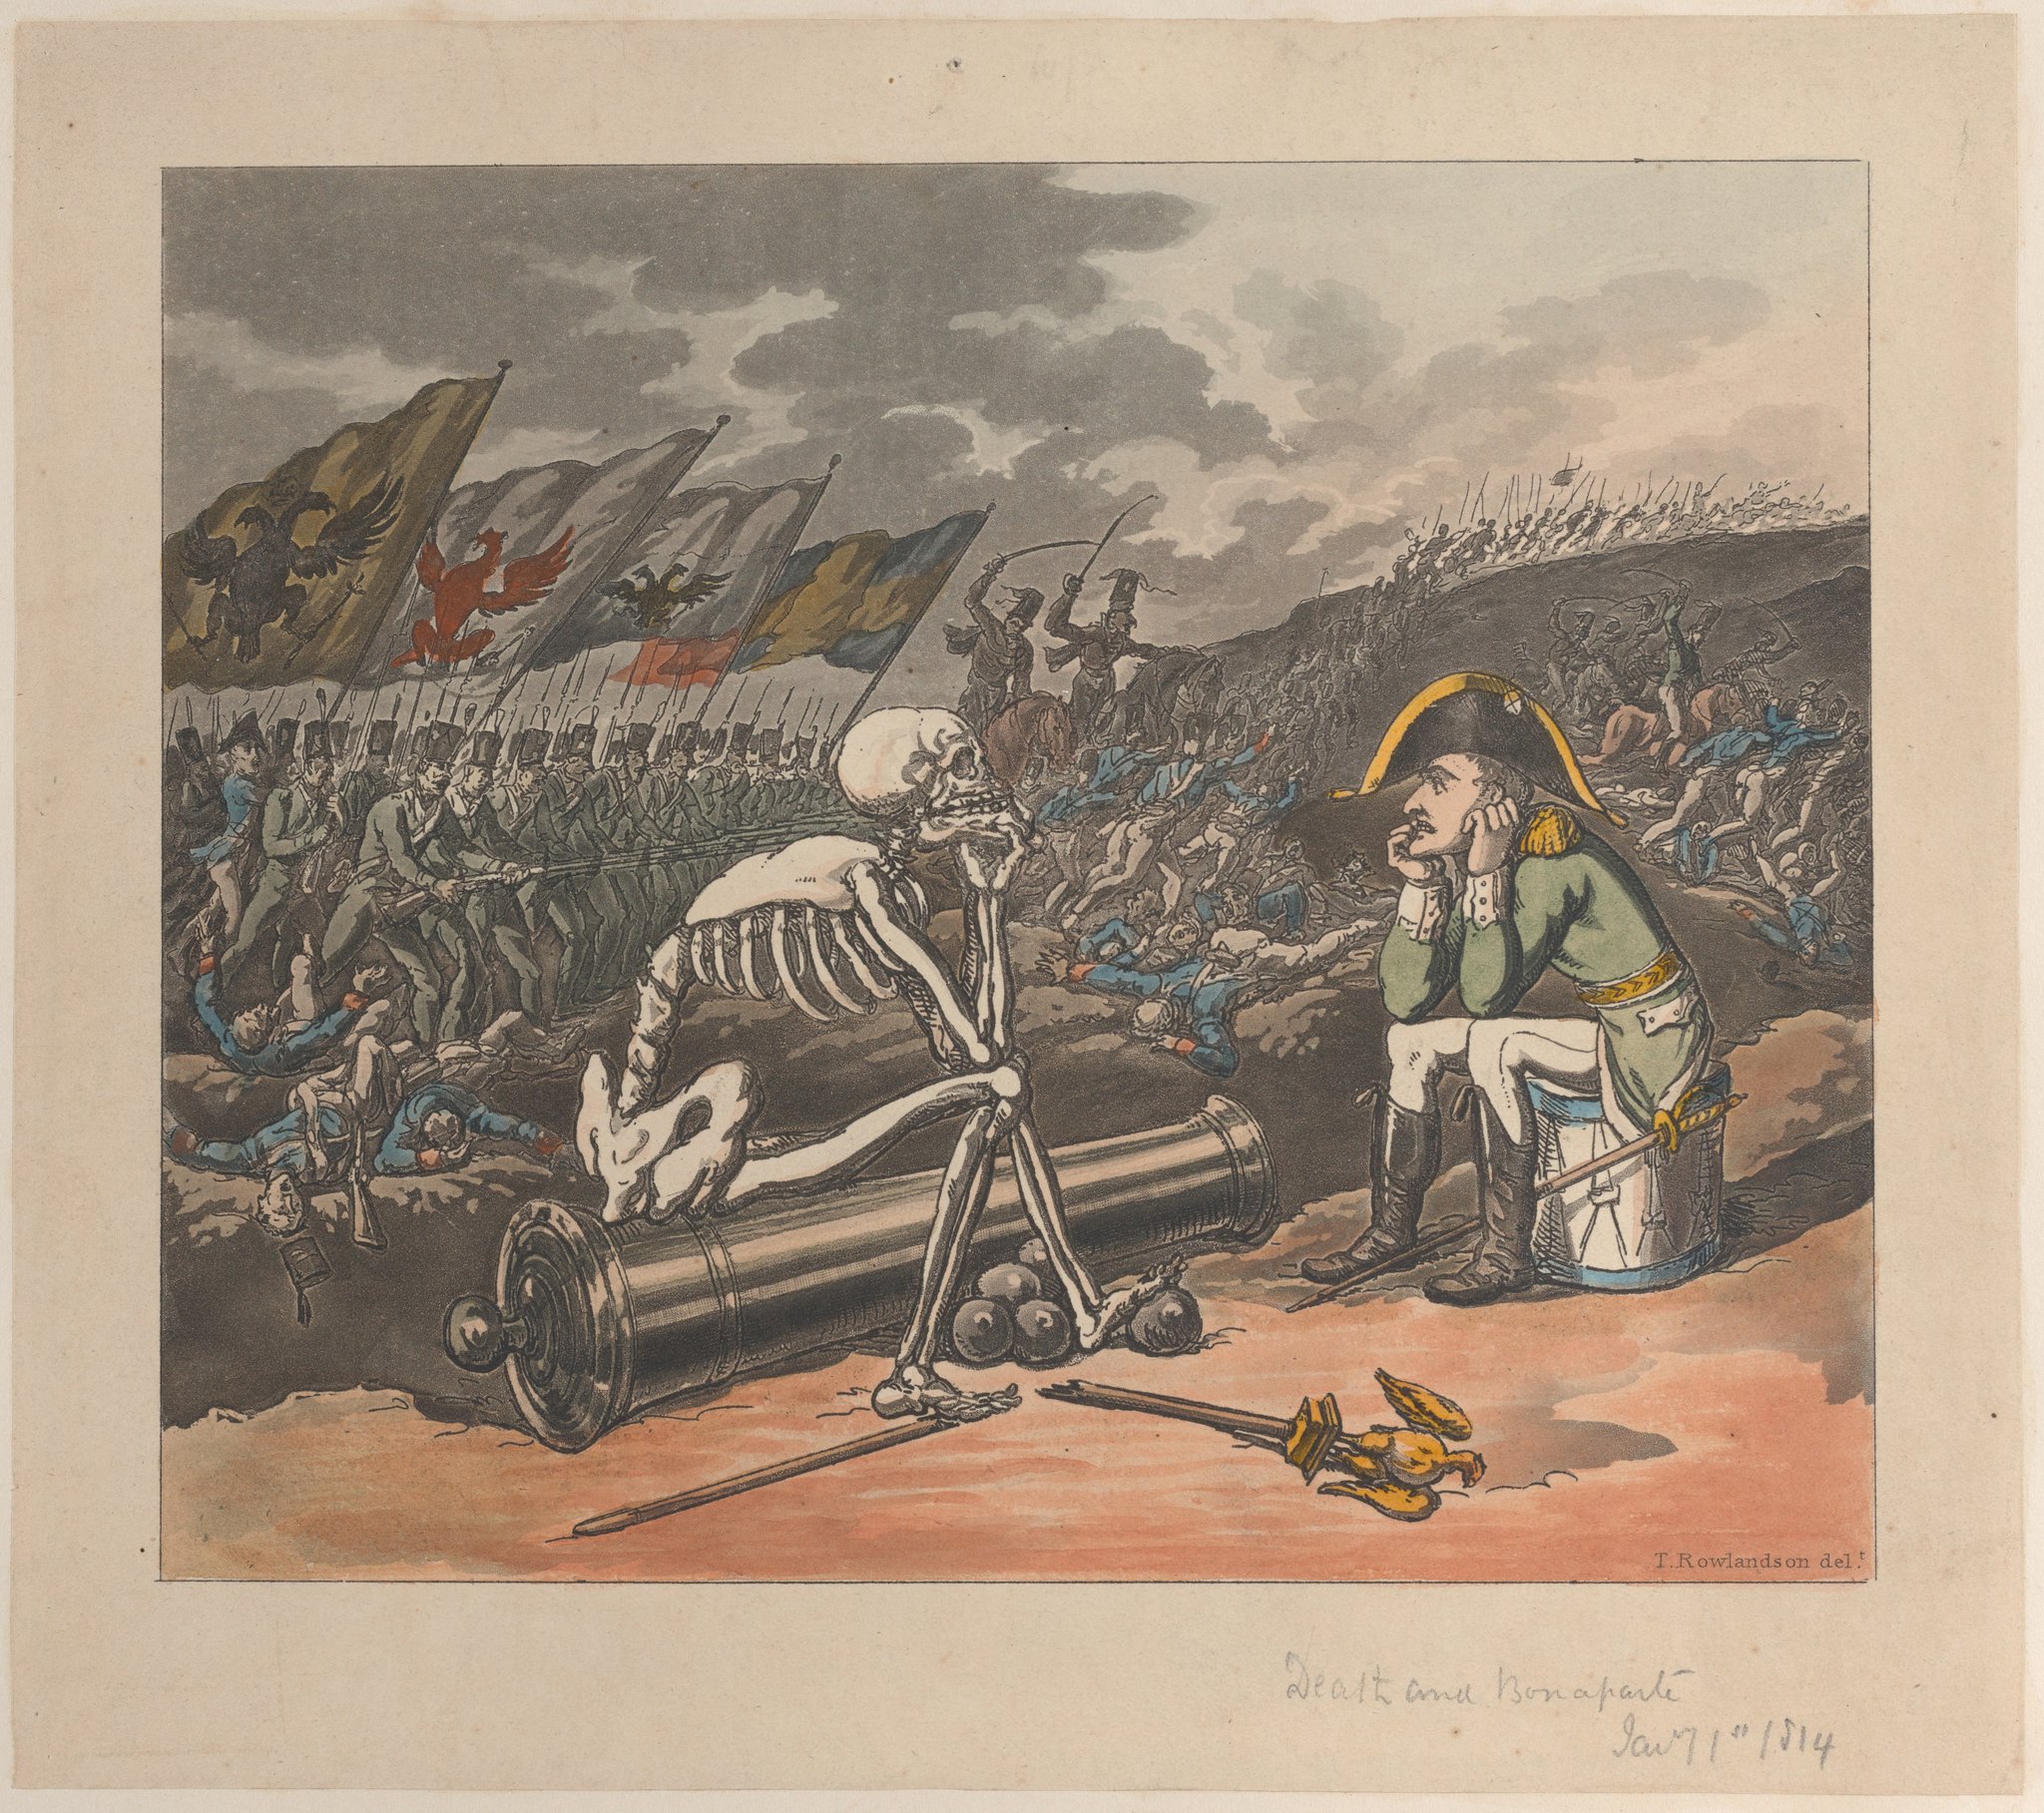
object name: print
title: Death and Bonaparte, The Two Kings of Terror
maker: thomas rowlandson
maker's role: artist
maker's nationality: british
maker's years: 1757-1827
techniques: etching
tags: satire,soldiers,cannons,napoleon i,skeletons,politics